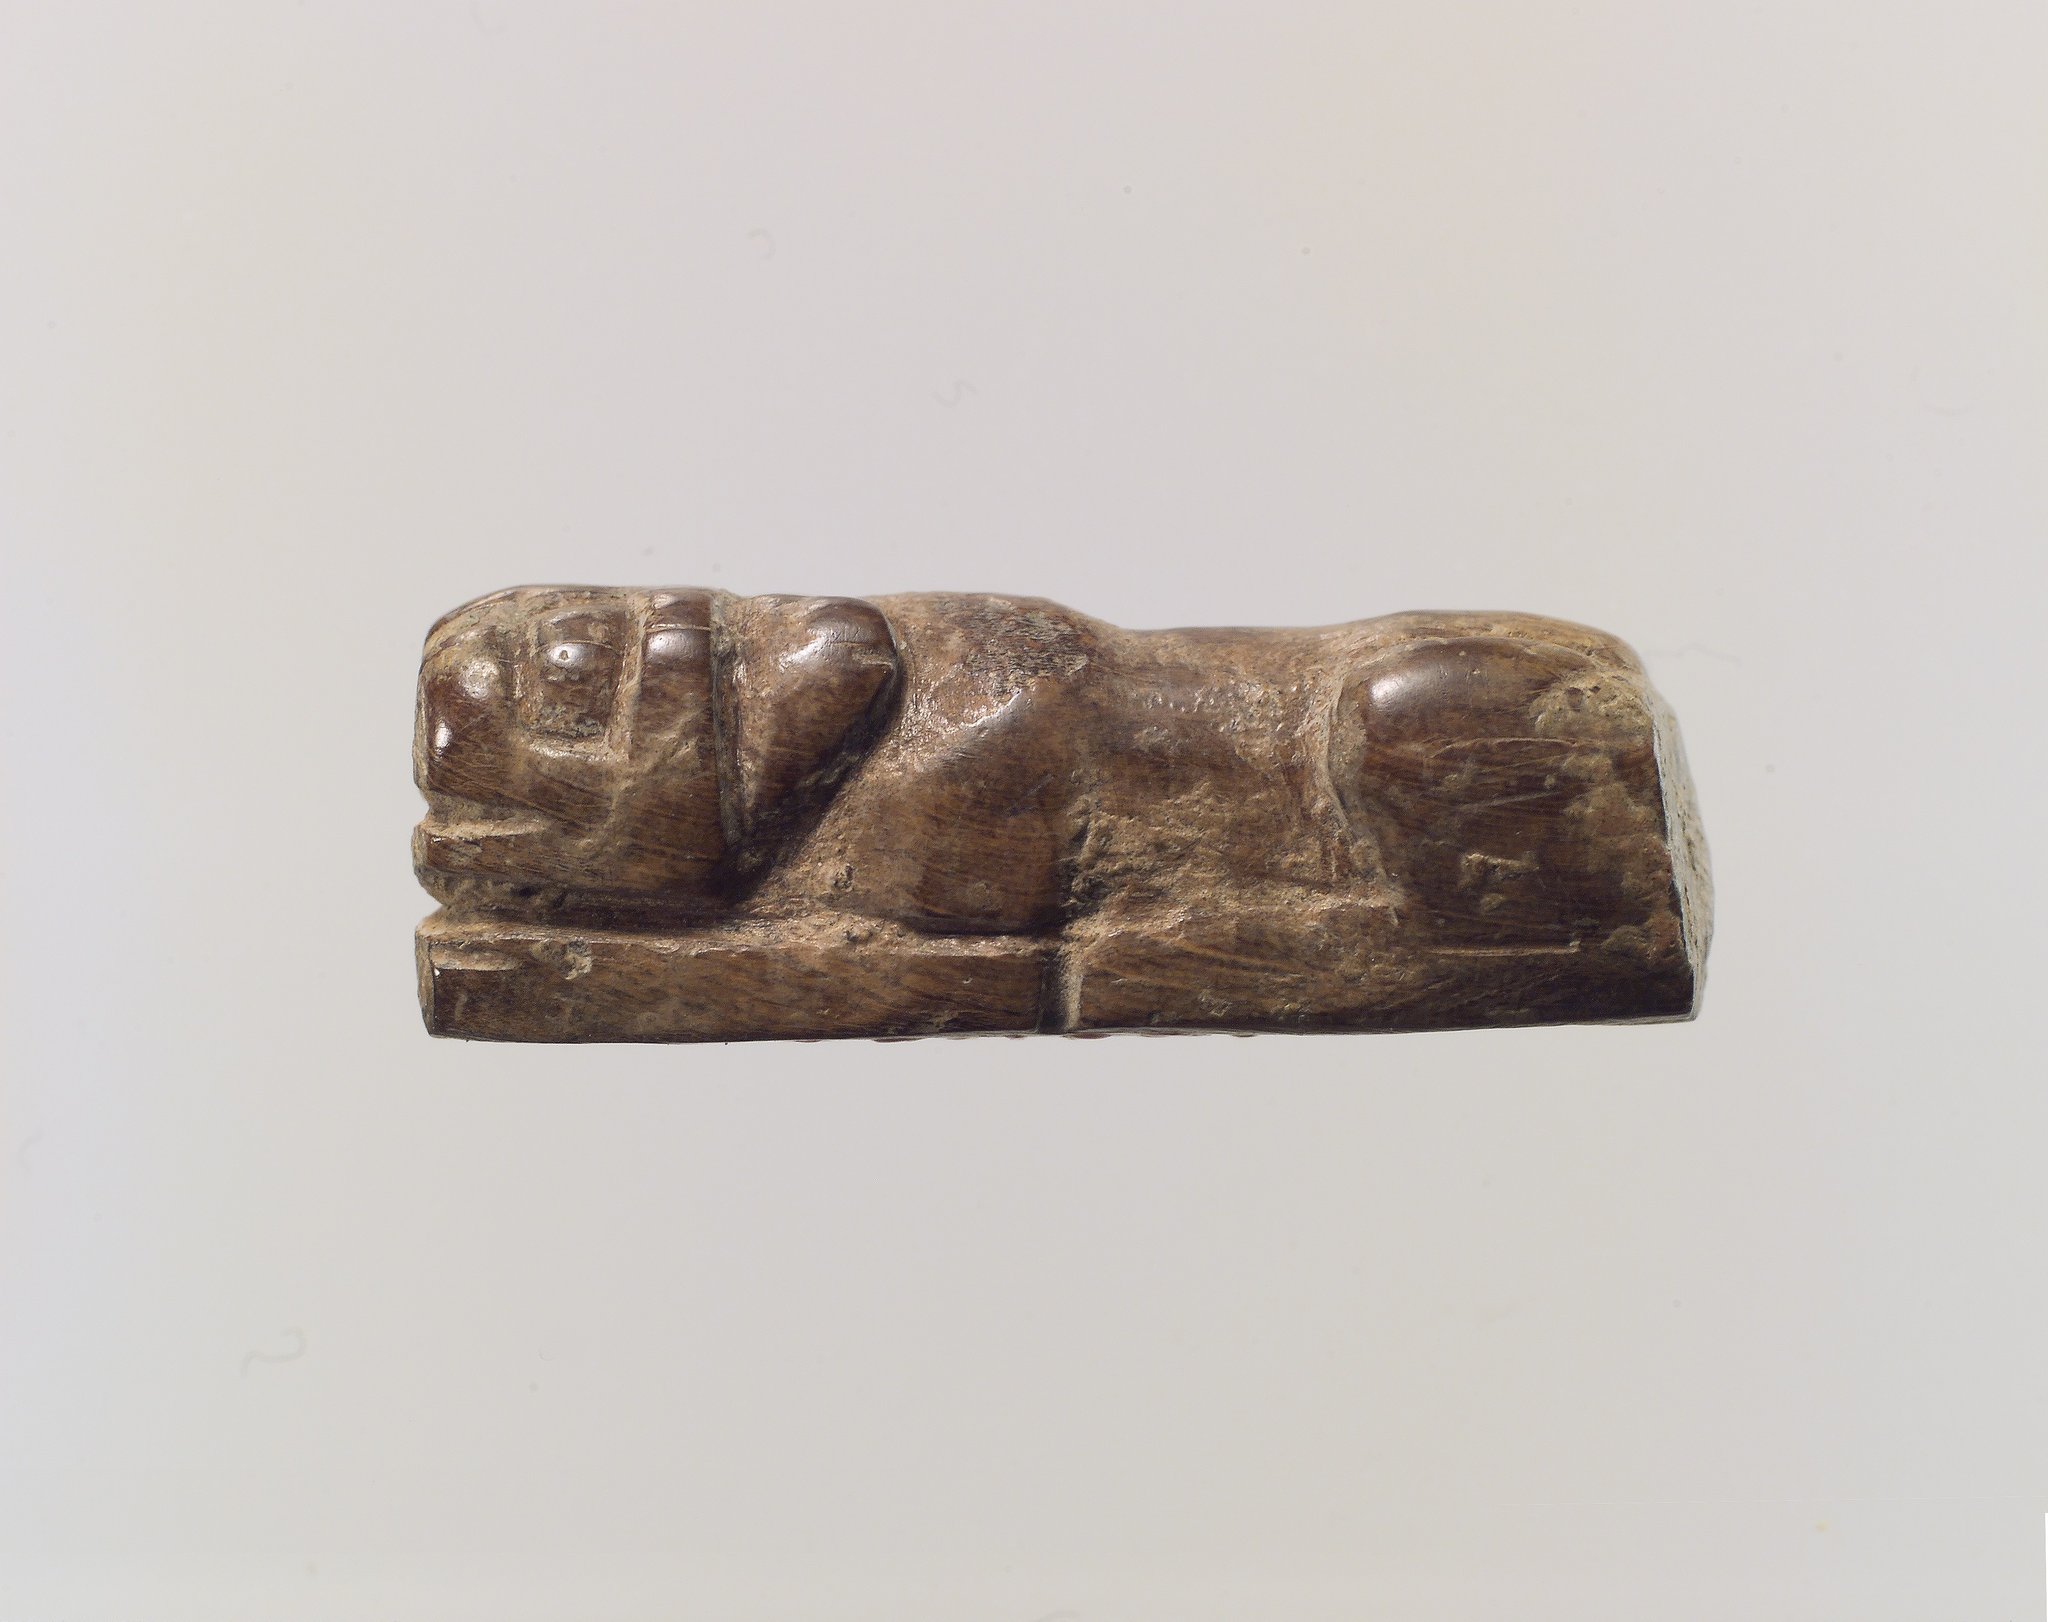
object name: sculpture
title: Figure of crouching lion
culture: iranian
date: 800-601 BCE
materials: ivory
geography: iran, luristan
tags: lions